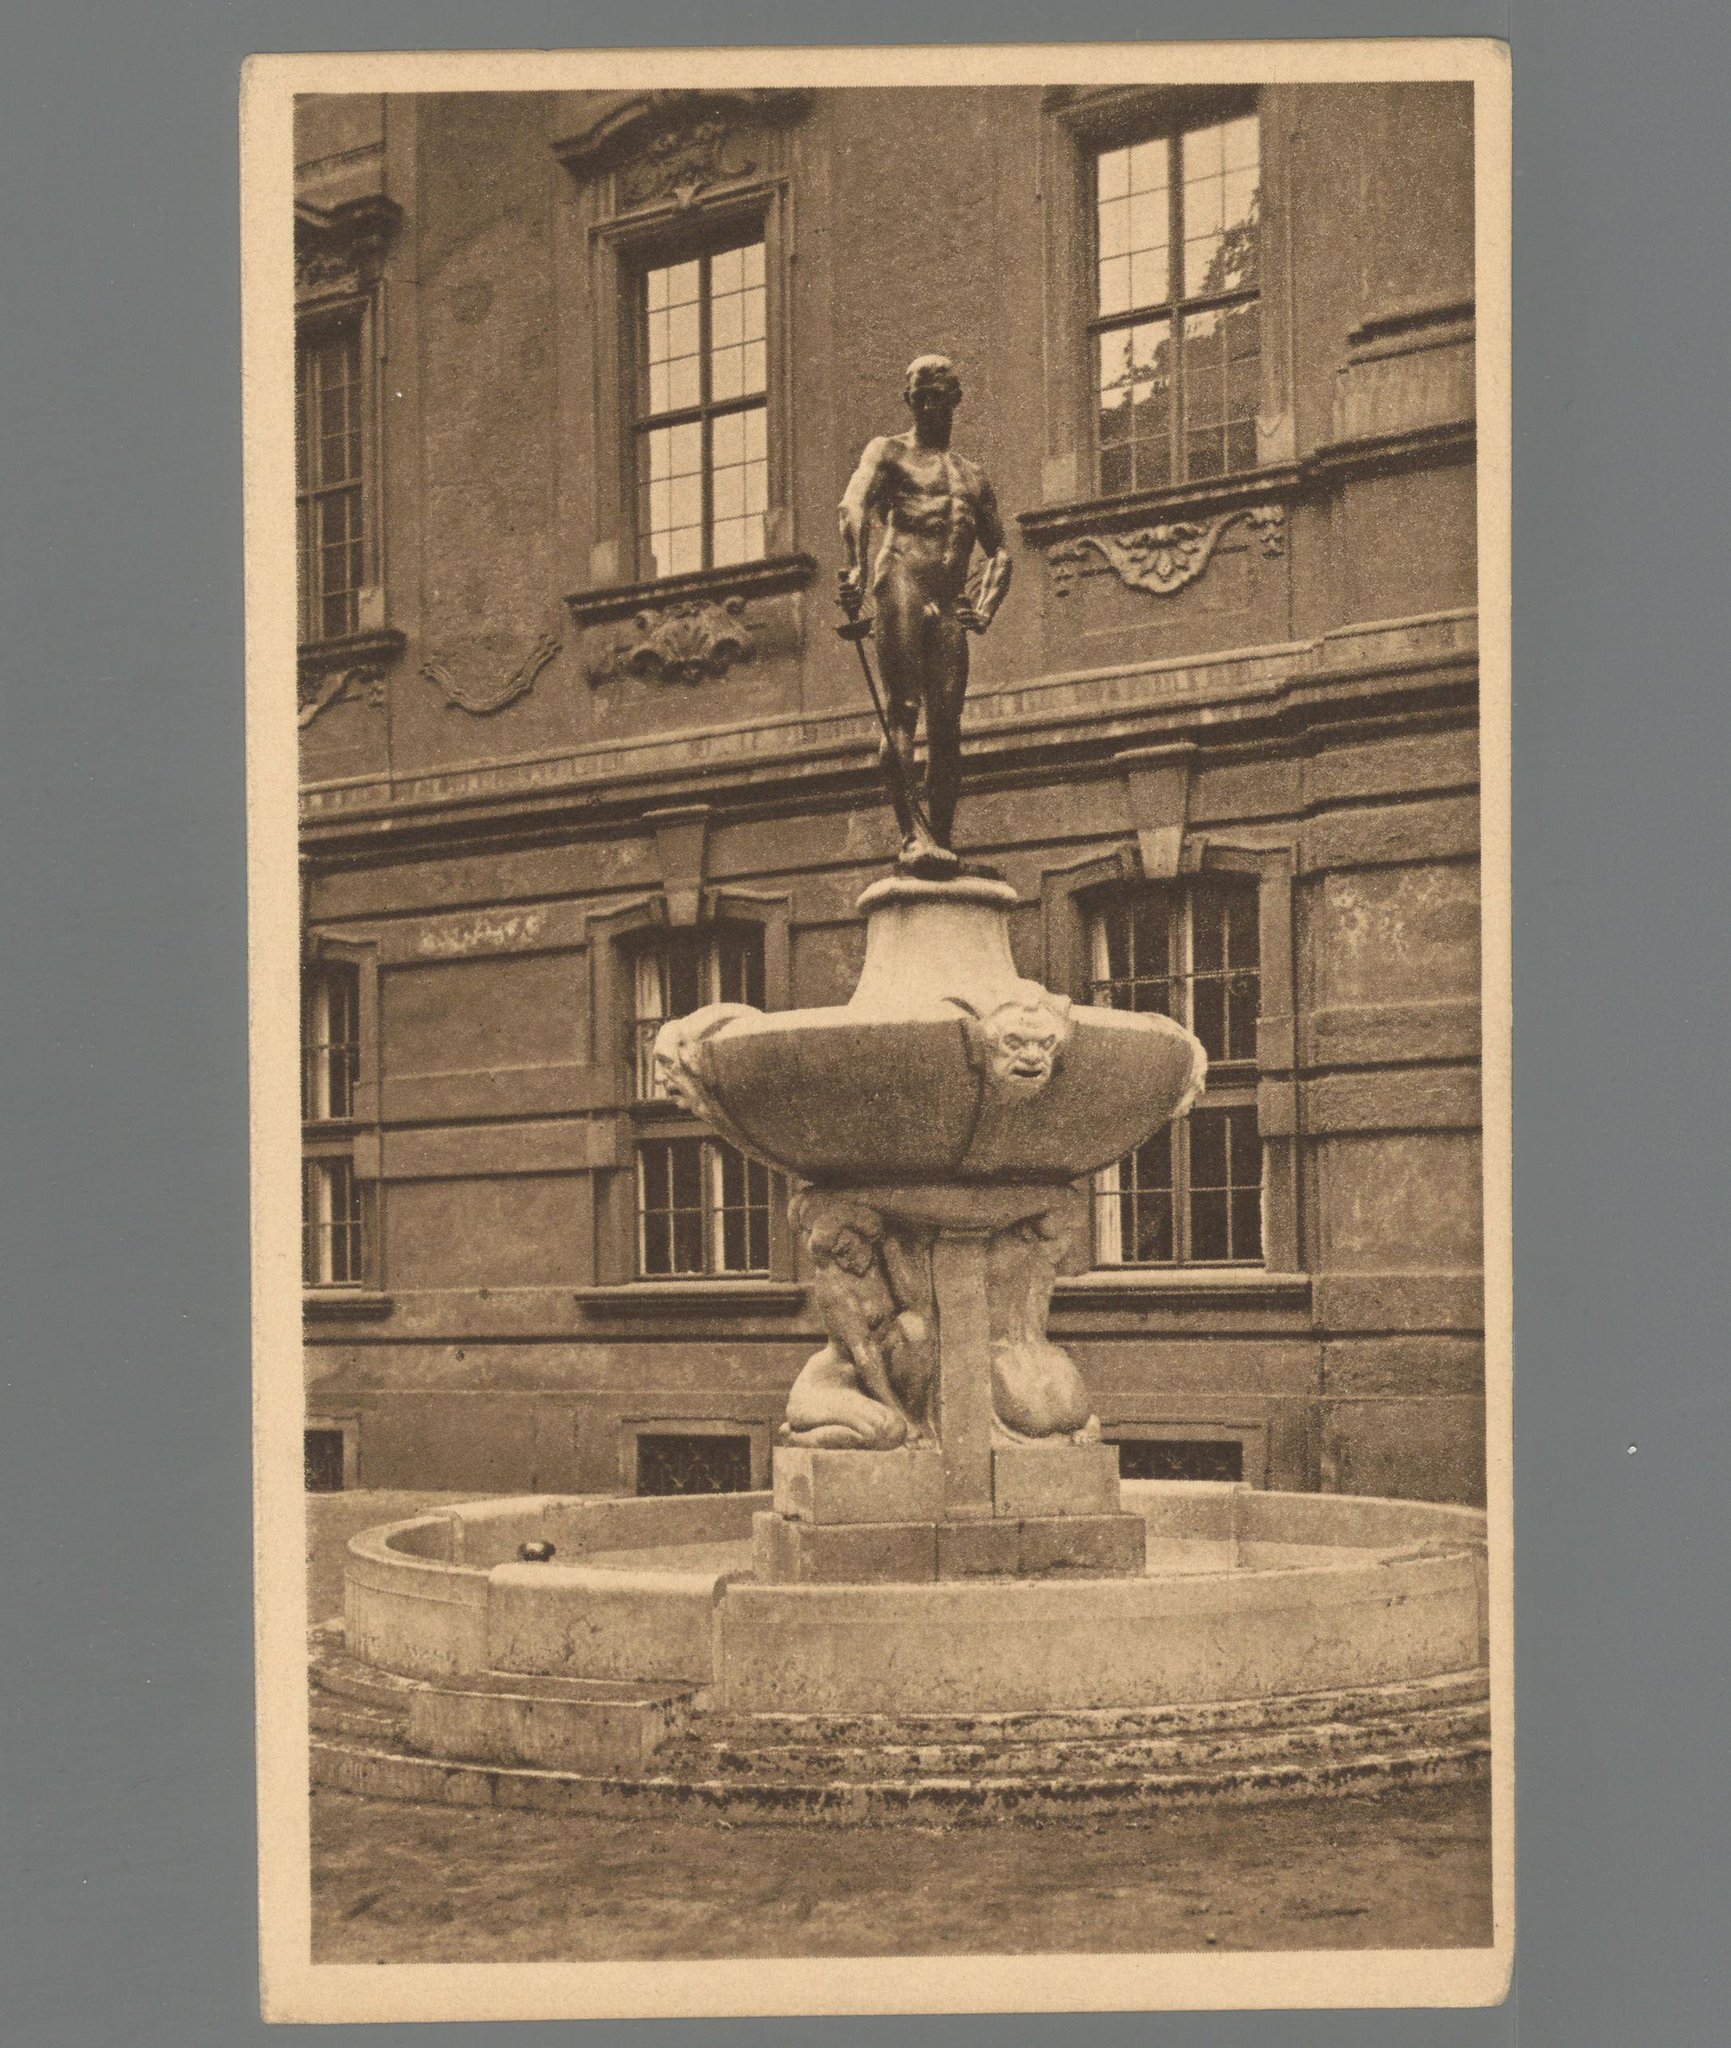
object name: ansichtkaart, prentbriefkaart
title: Breslau, Fechter-Brunnen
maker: Anonymous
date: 1905-1930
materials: cardboard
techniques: rotogravure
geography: berlin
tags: university building, college, ornamental fountain